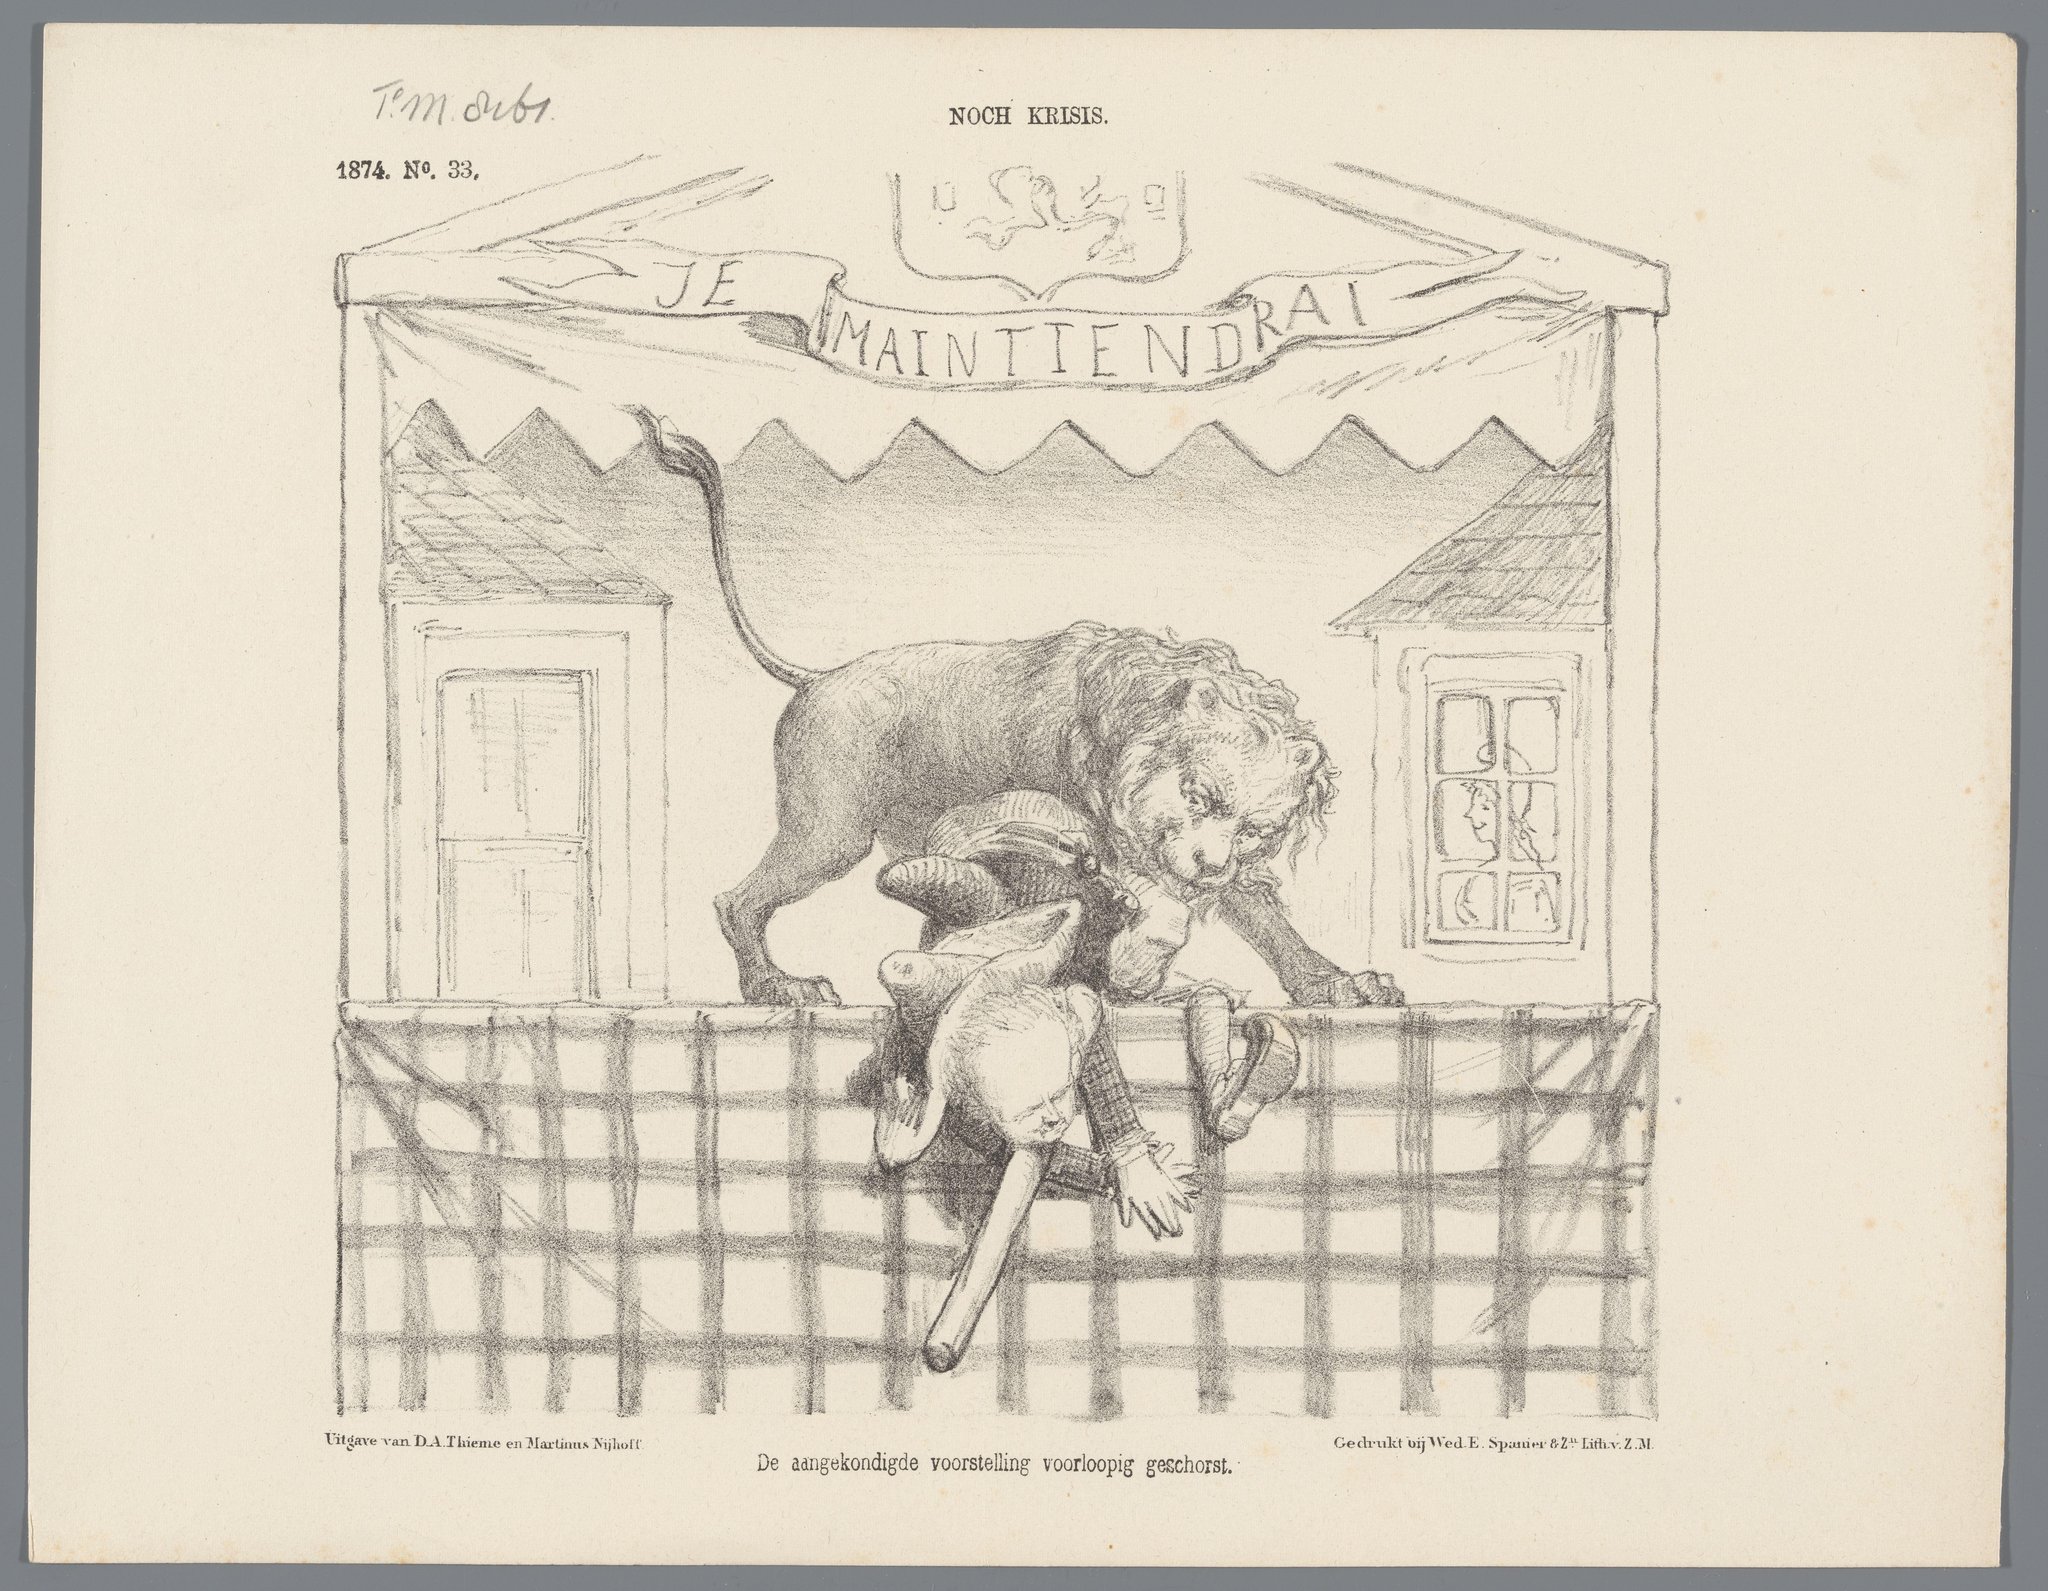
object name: cartoon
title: Noch krisis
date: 1874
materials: paper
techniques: lithograph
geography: arnhem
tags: amsterdam, politician, puppet and marionette show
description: Spotprent op het tijdelijk mislukken van een ministerie Heemskerk, 1874. De Nederlandse leeuw verscheurt de pop Jan Klaassen. Plaat verschenen bij het weekblad De Nederlandsche Spectator, nr. 33, 1874.